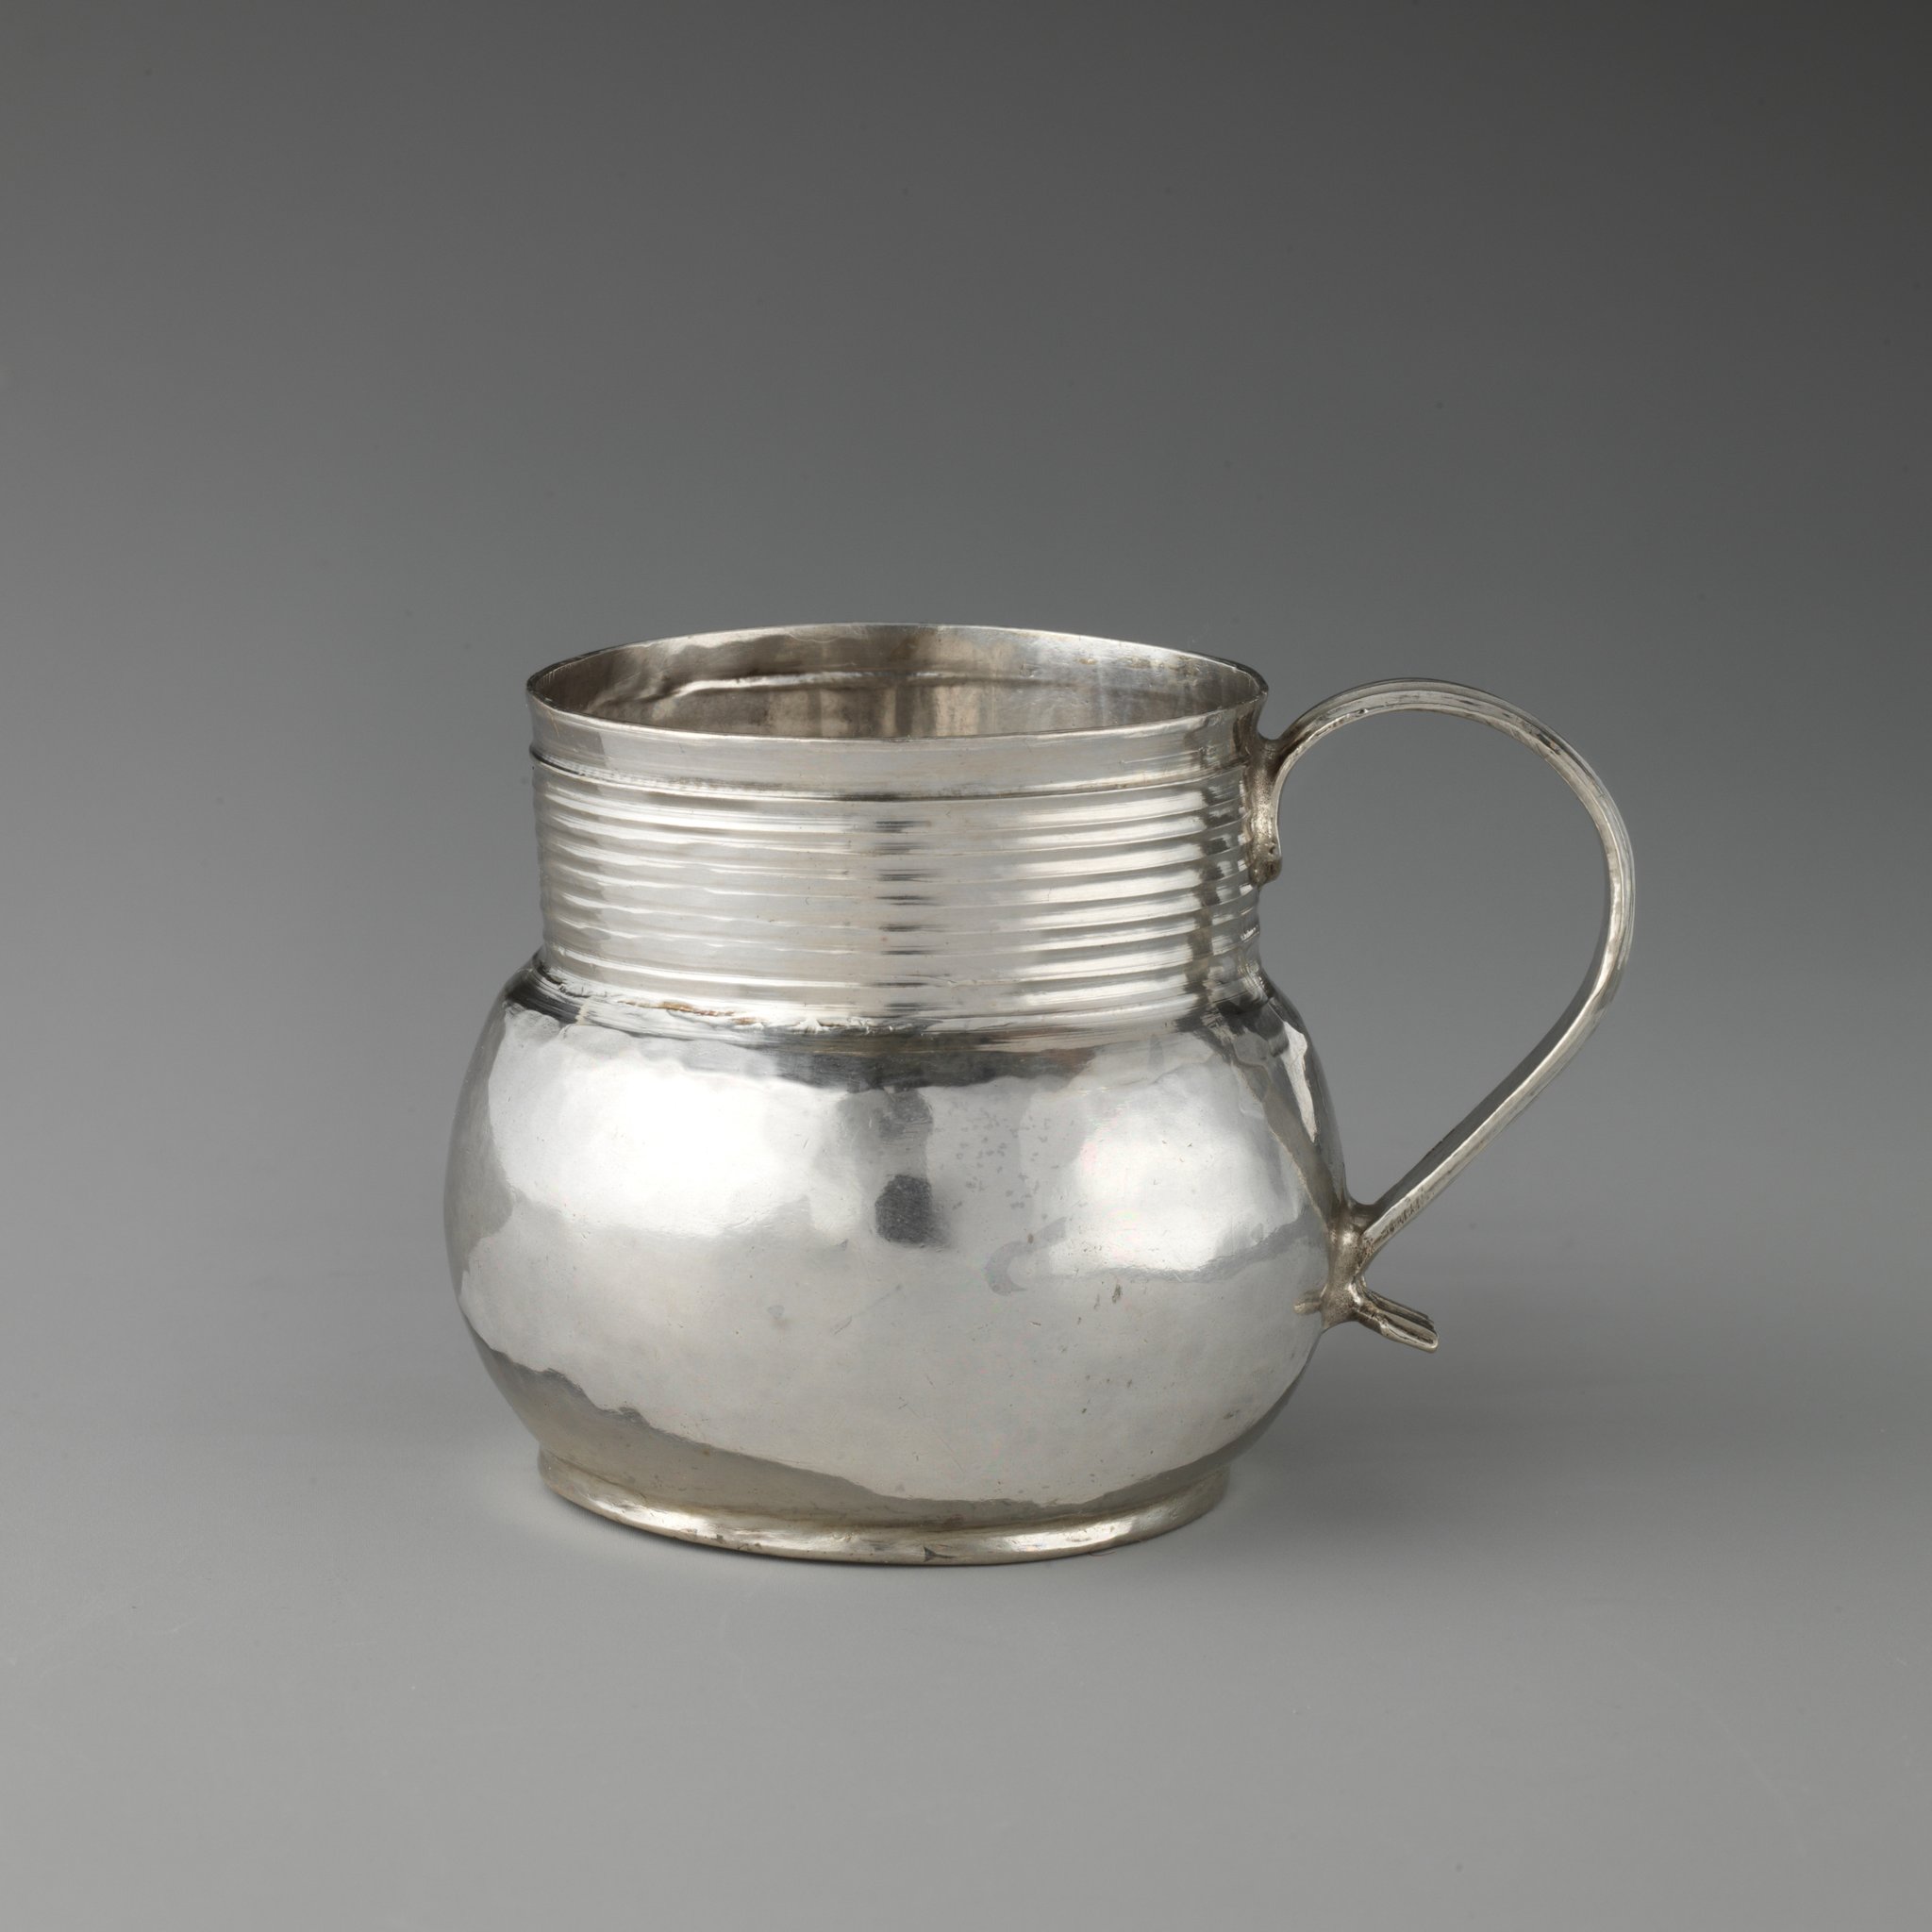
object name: mug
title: Miniature mug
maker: b m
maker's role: maker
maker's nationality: british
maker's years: 1640-1699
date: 1683-1684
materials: silver